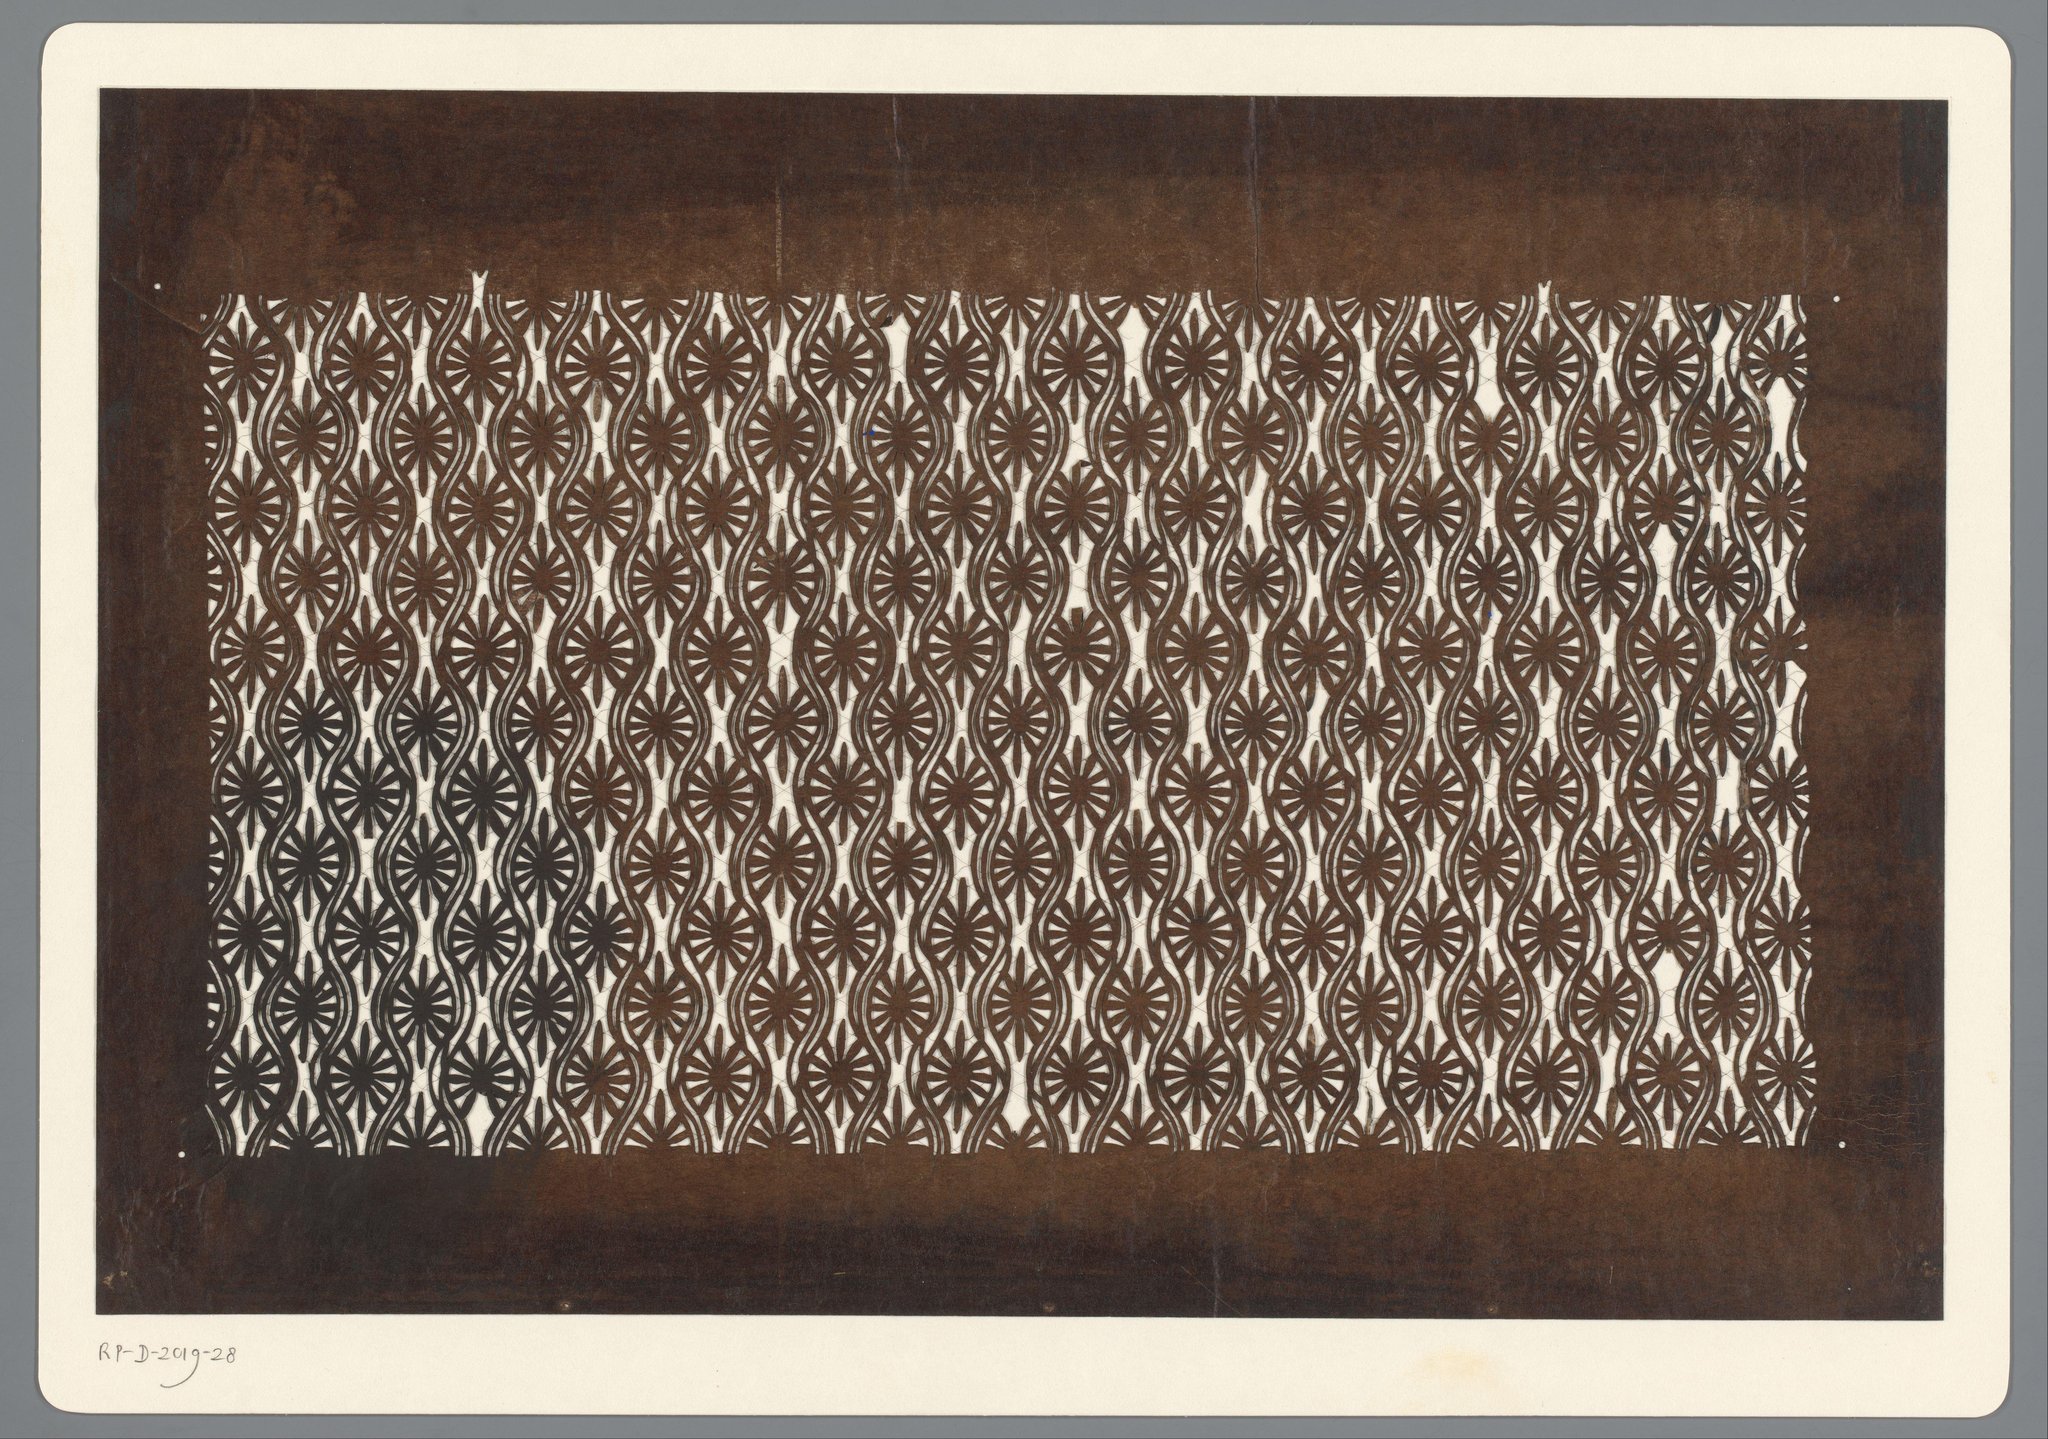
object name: katagami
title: Sjabloon met bloem tussen golvende lijnen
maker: Anonymous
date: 1800-1909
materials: paper, silk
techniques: cutting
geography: japan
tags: flowers ~ ornament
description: Japanse sjabloon (katagami) met een patroon van een gestileerde bloem tussen verticaal golvende lijnen.